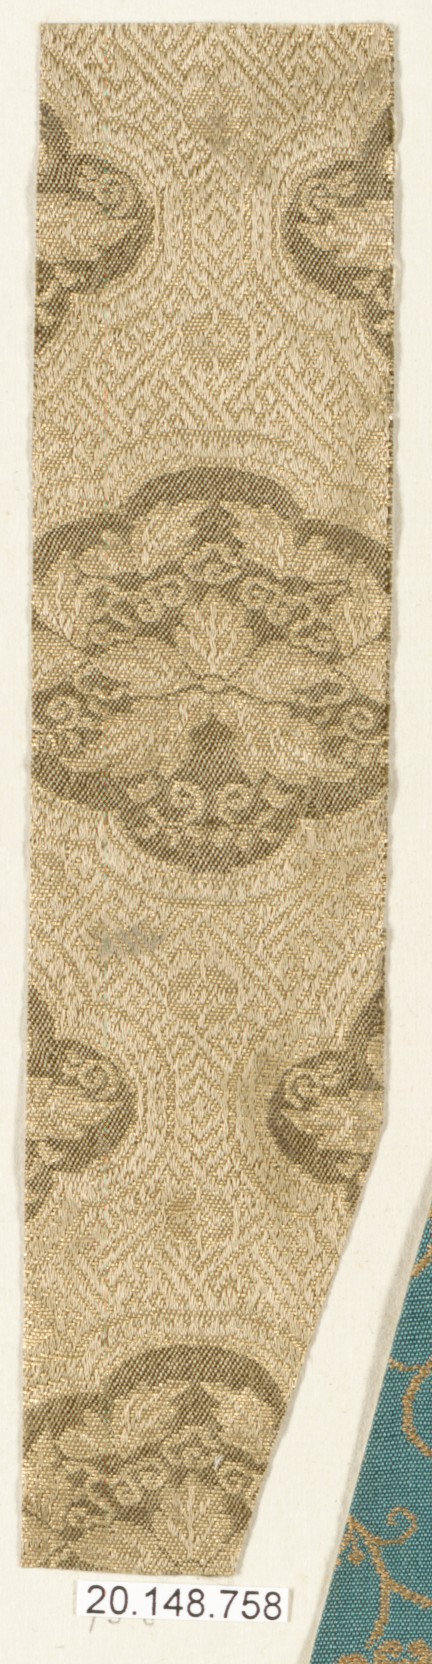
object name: piece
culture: japanese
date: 1701-1800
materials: silk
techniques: compound weave